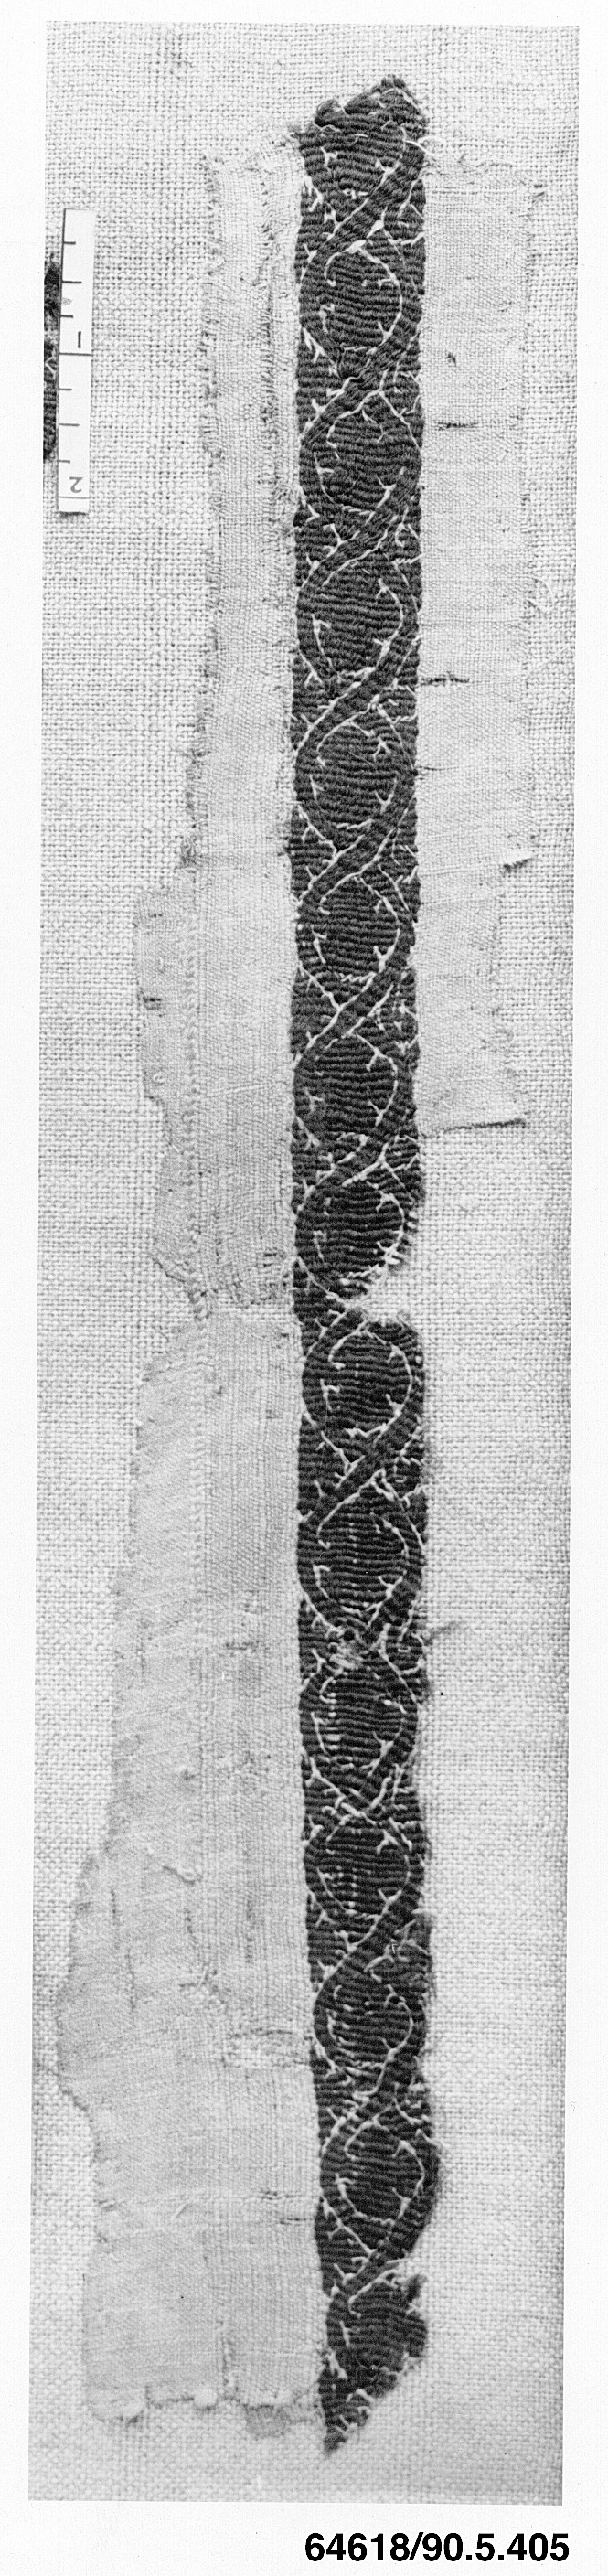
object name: textile fragment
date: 201-400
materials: linen, wool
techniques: weave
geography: egypt